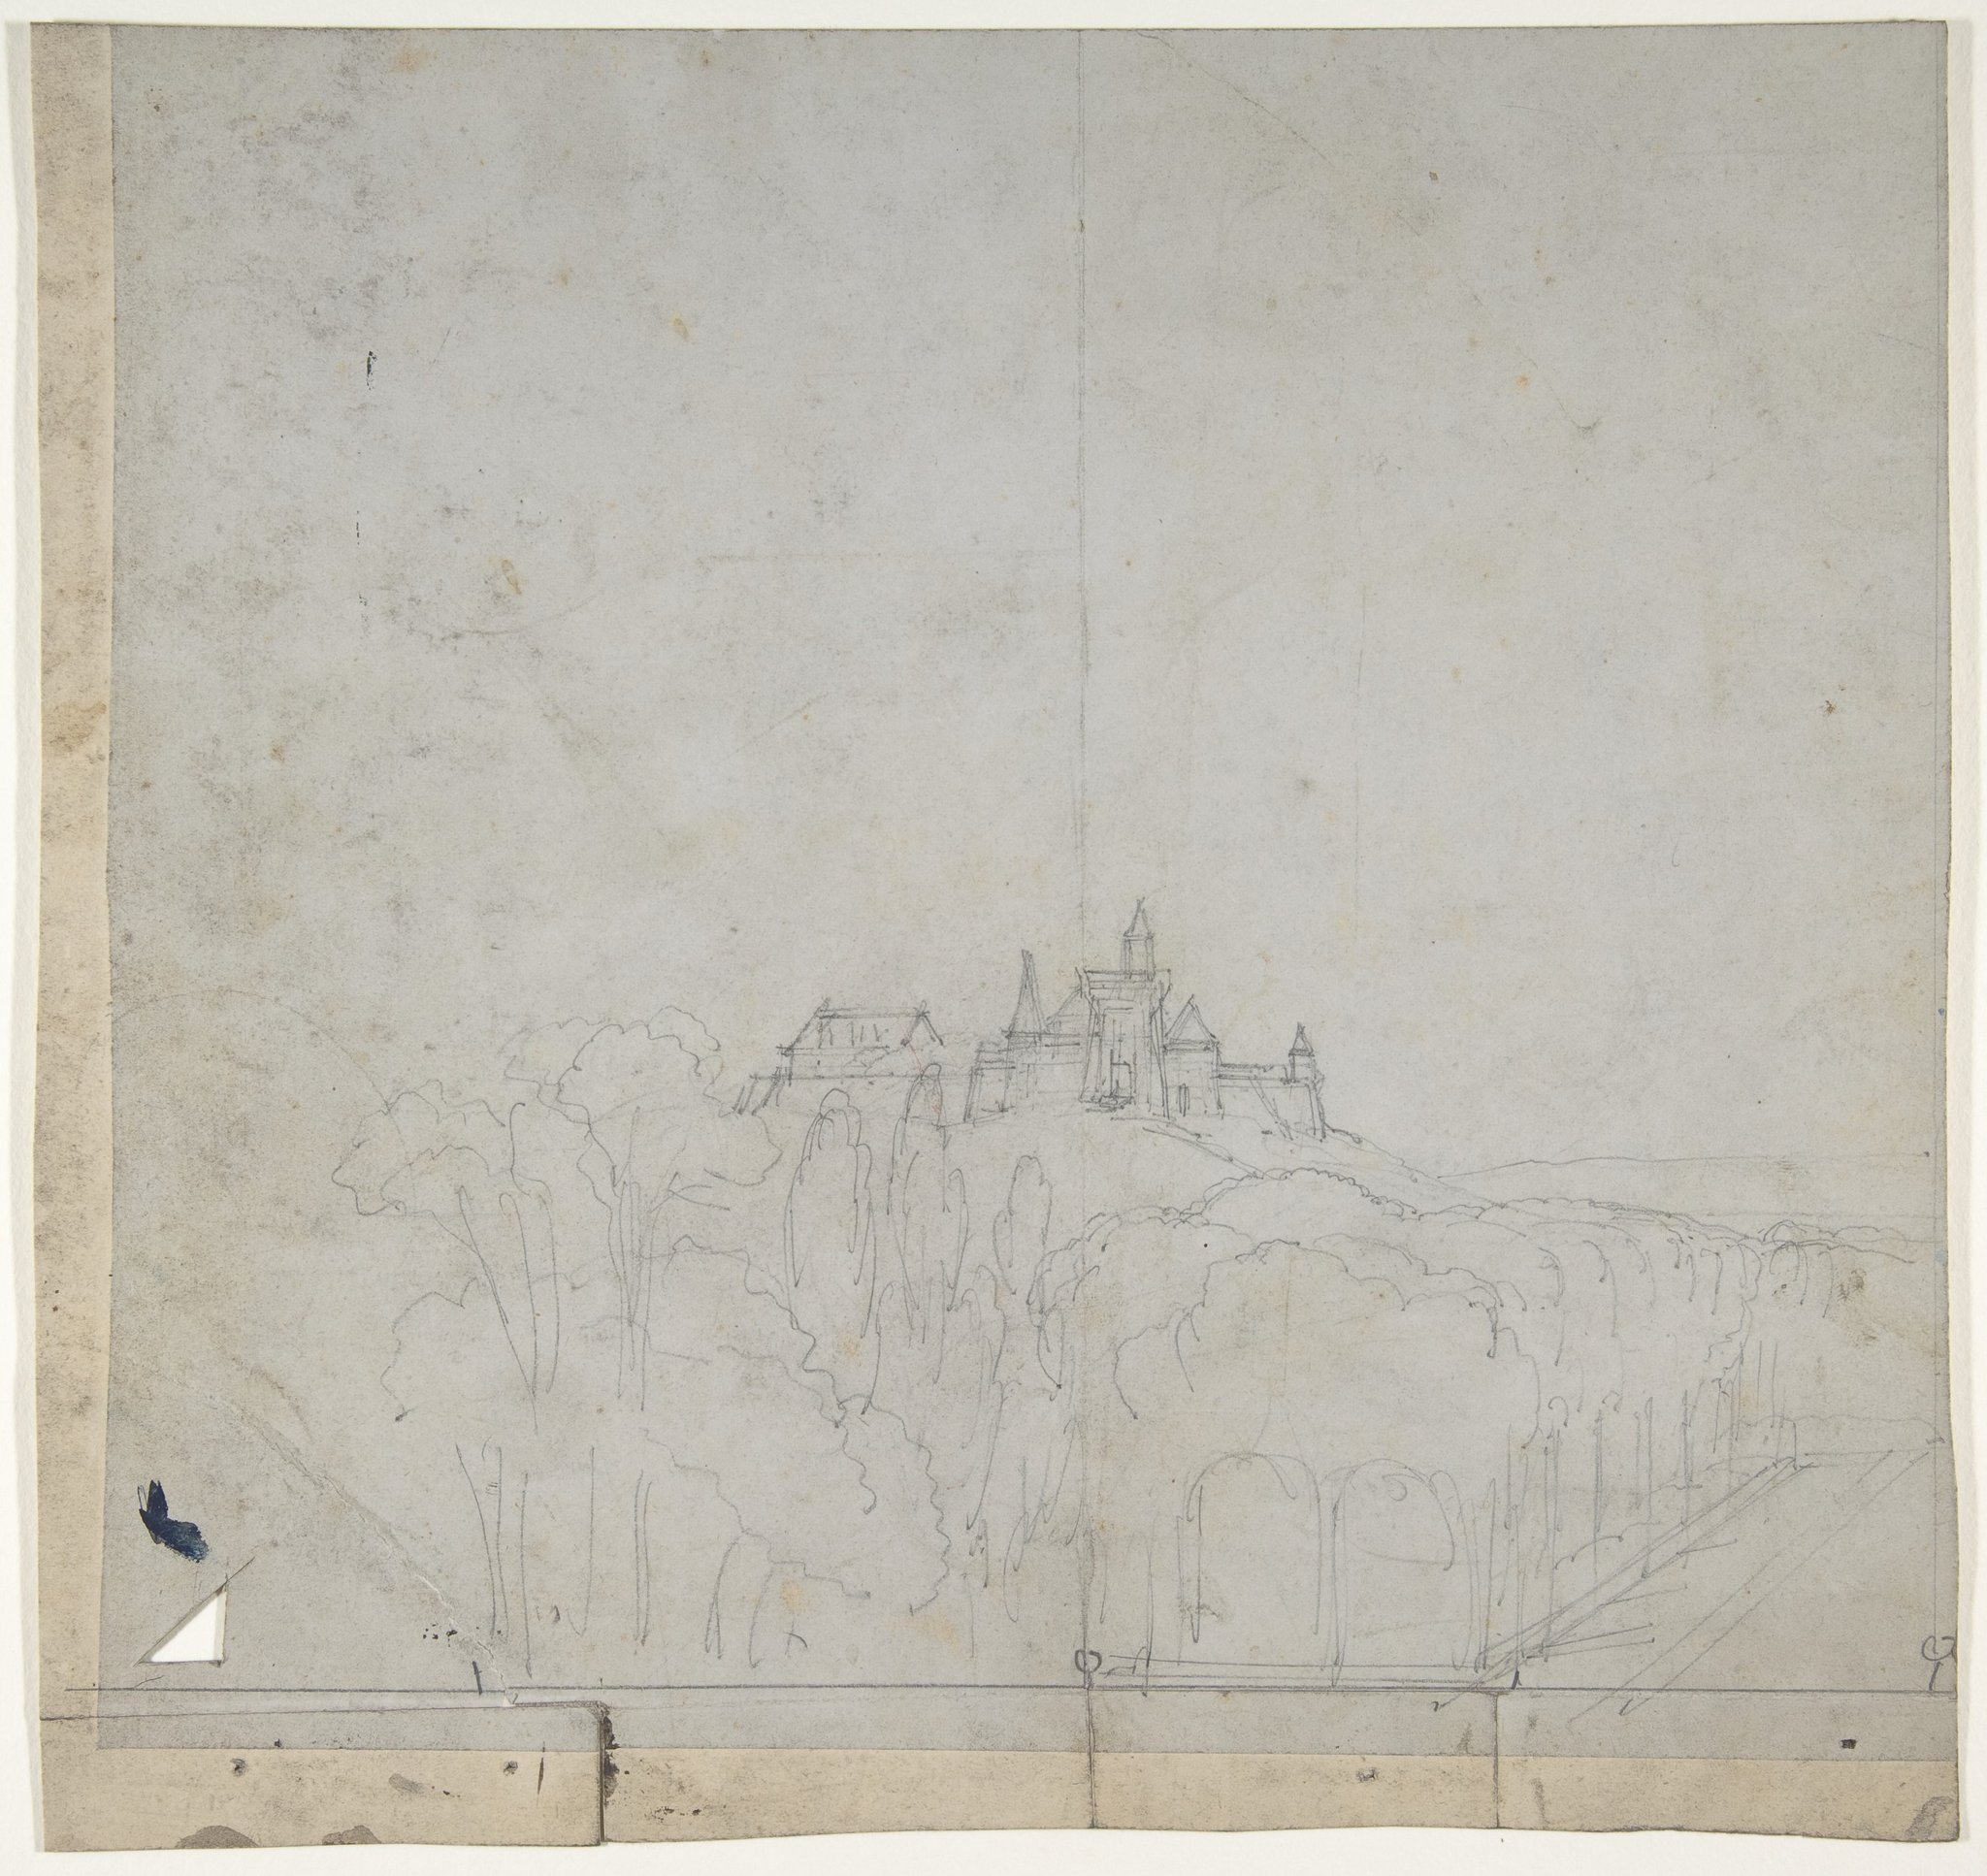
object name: drawing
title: Design for a Stage Set at the Opéra, Paris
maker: eugène cicéri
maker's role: artist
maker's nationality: french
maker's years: 1813-1890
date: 1830-1890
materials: graphite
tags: stage design